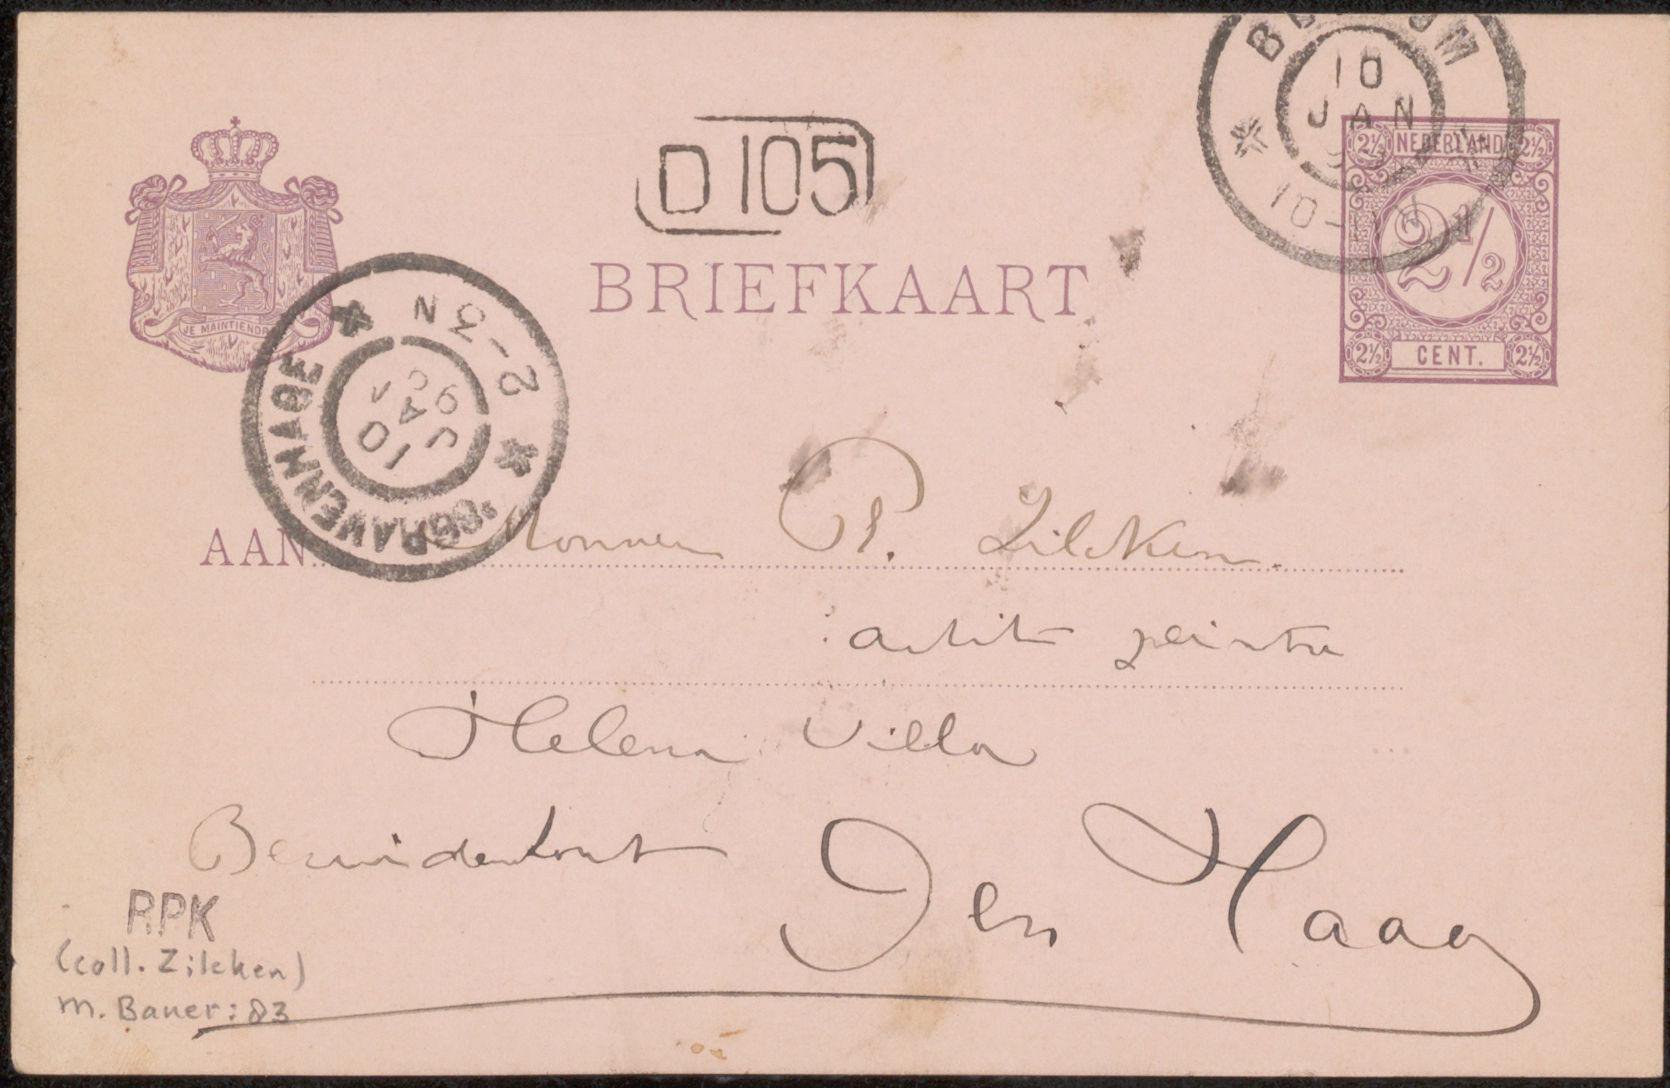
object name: postcard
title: Briefkaart aan Philip Zilcken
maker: marius bauer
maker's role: draughtsman, print maker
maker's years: 1867-1932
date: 1877-1932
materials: cardboard, ink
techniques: pen, writing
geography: bussum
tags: painter, philip zilcken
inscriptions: collector's mark: ‘RPK’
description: Gedateerd 10 januari XXXX op poststempel.